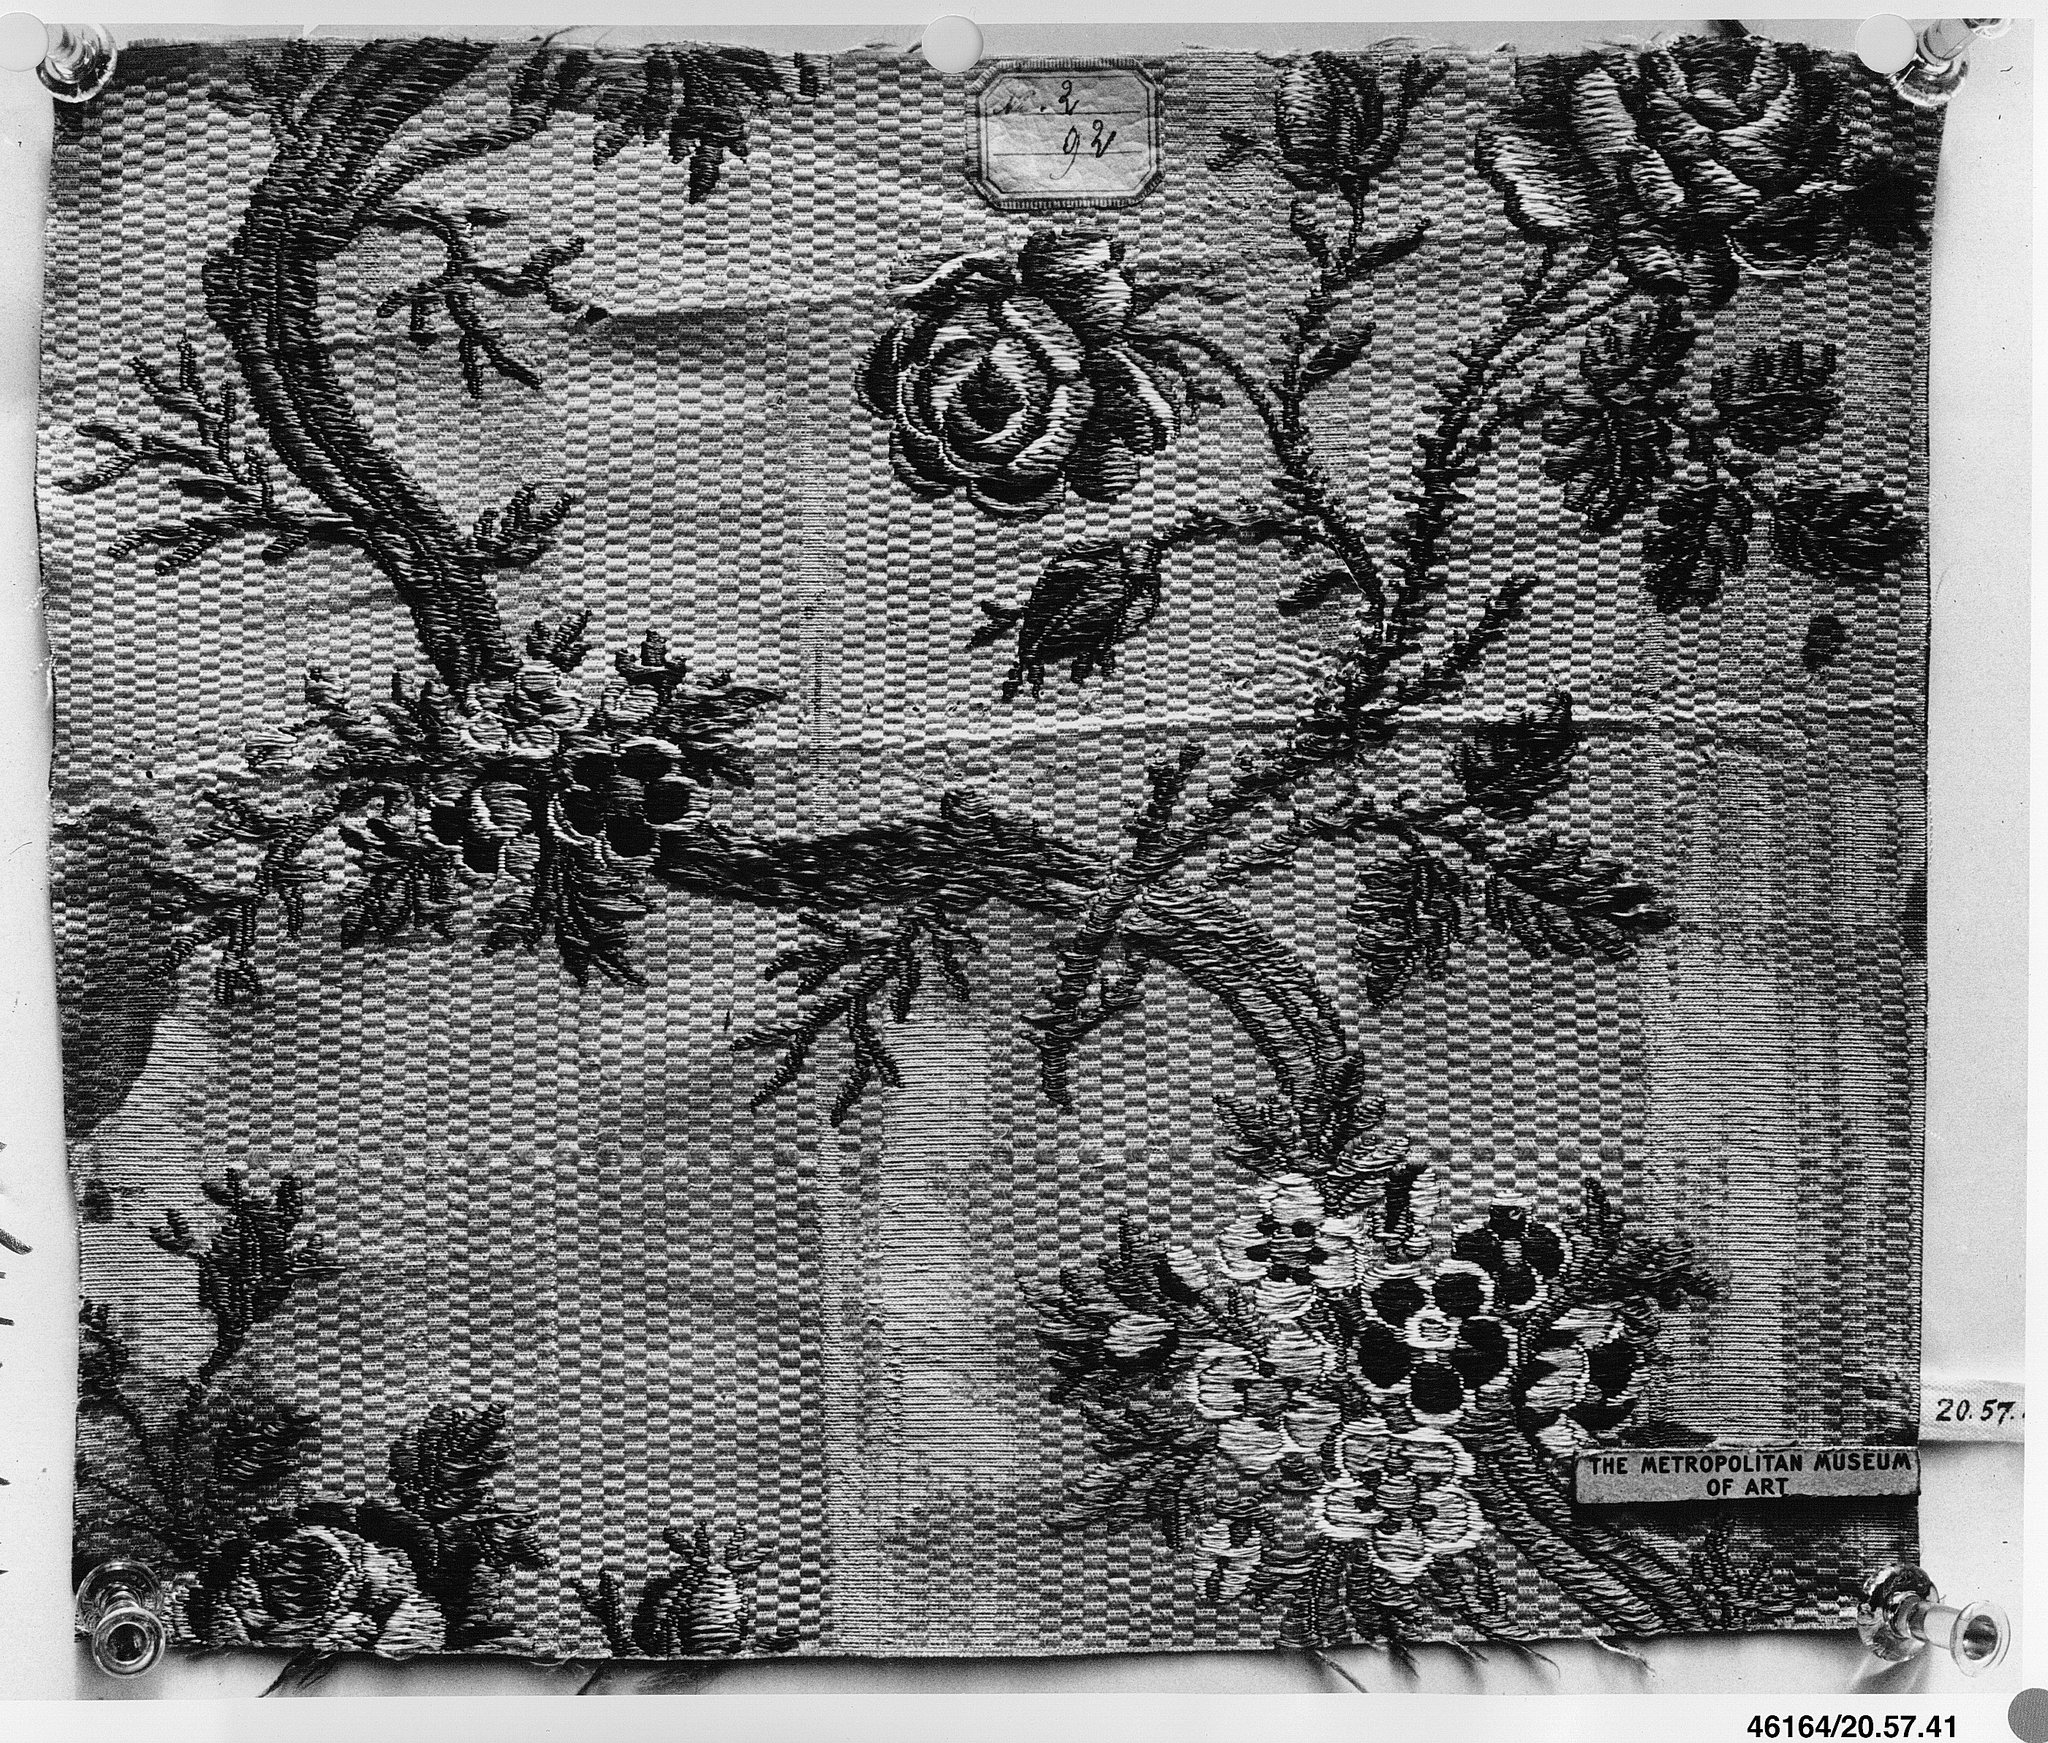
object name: piece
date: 1760-1770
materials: silk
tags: roses,leaves